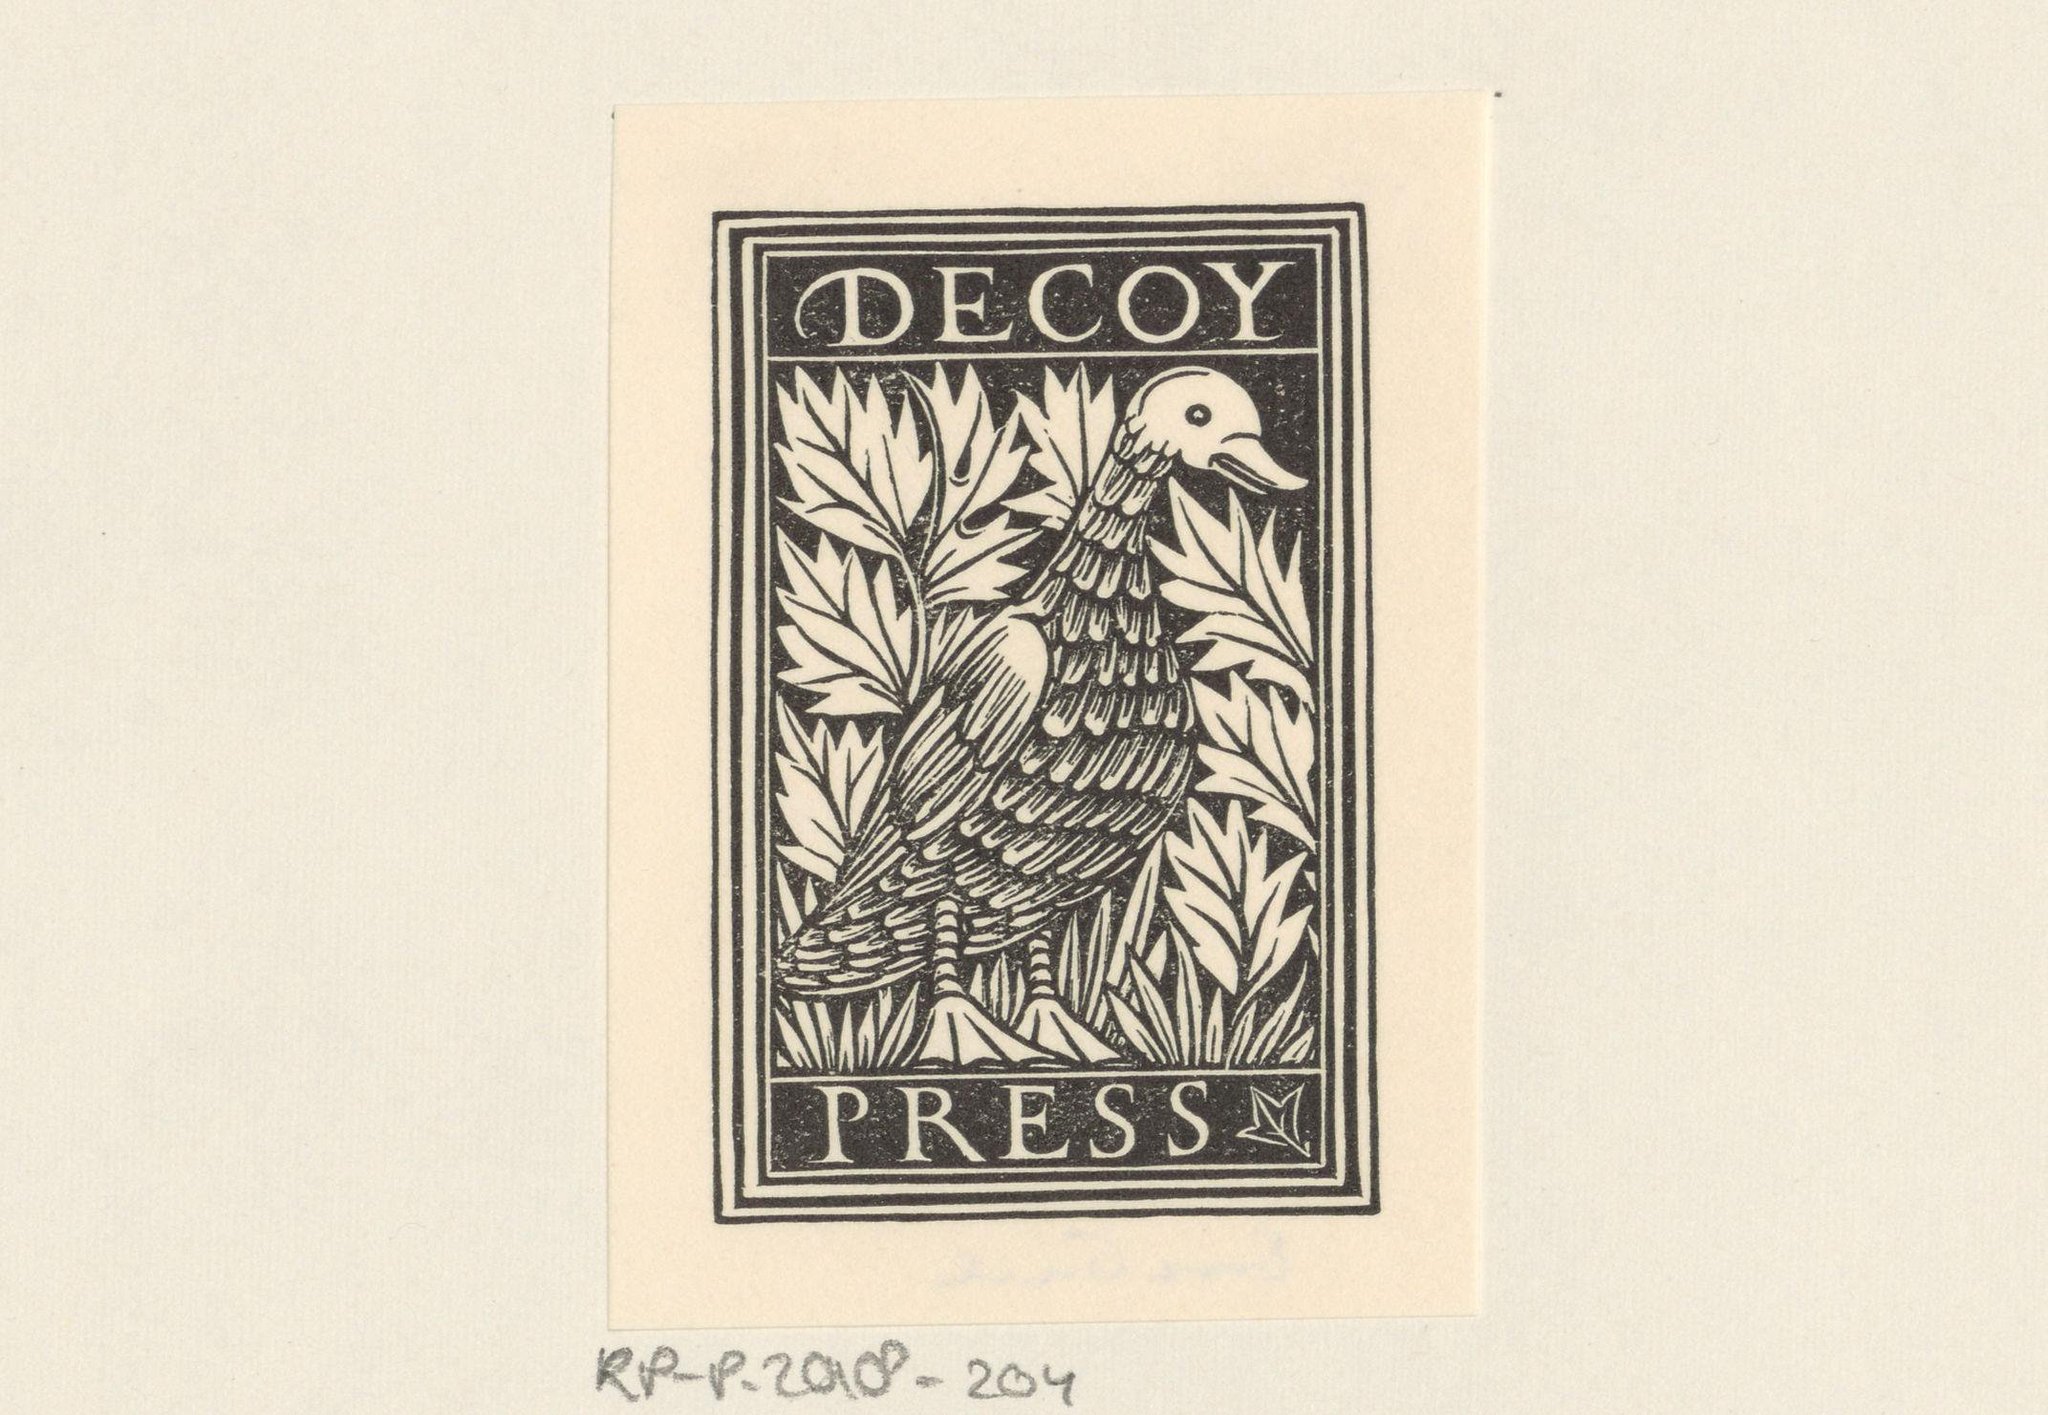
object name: bookplate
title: Ex libris van de Decoy Press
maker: eric gill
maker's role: print maker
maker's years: 1882-1940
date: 1920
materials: paper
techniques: engraving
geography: england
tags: water-birds: duck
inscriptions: inscription: ‘Eric Gill’